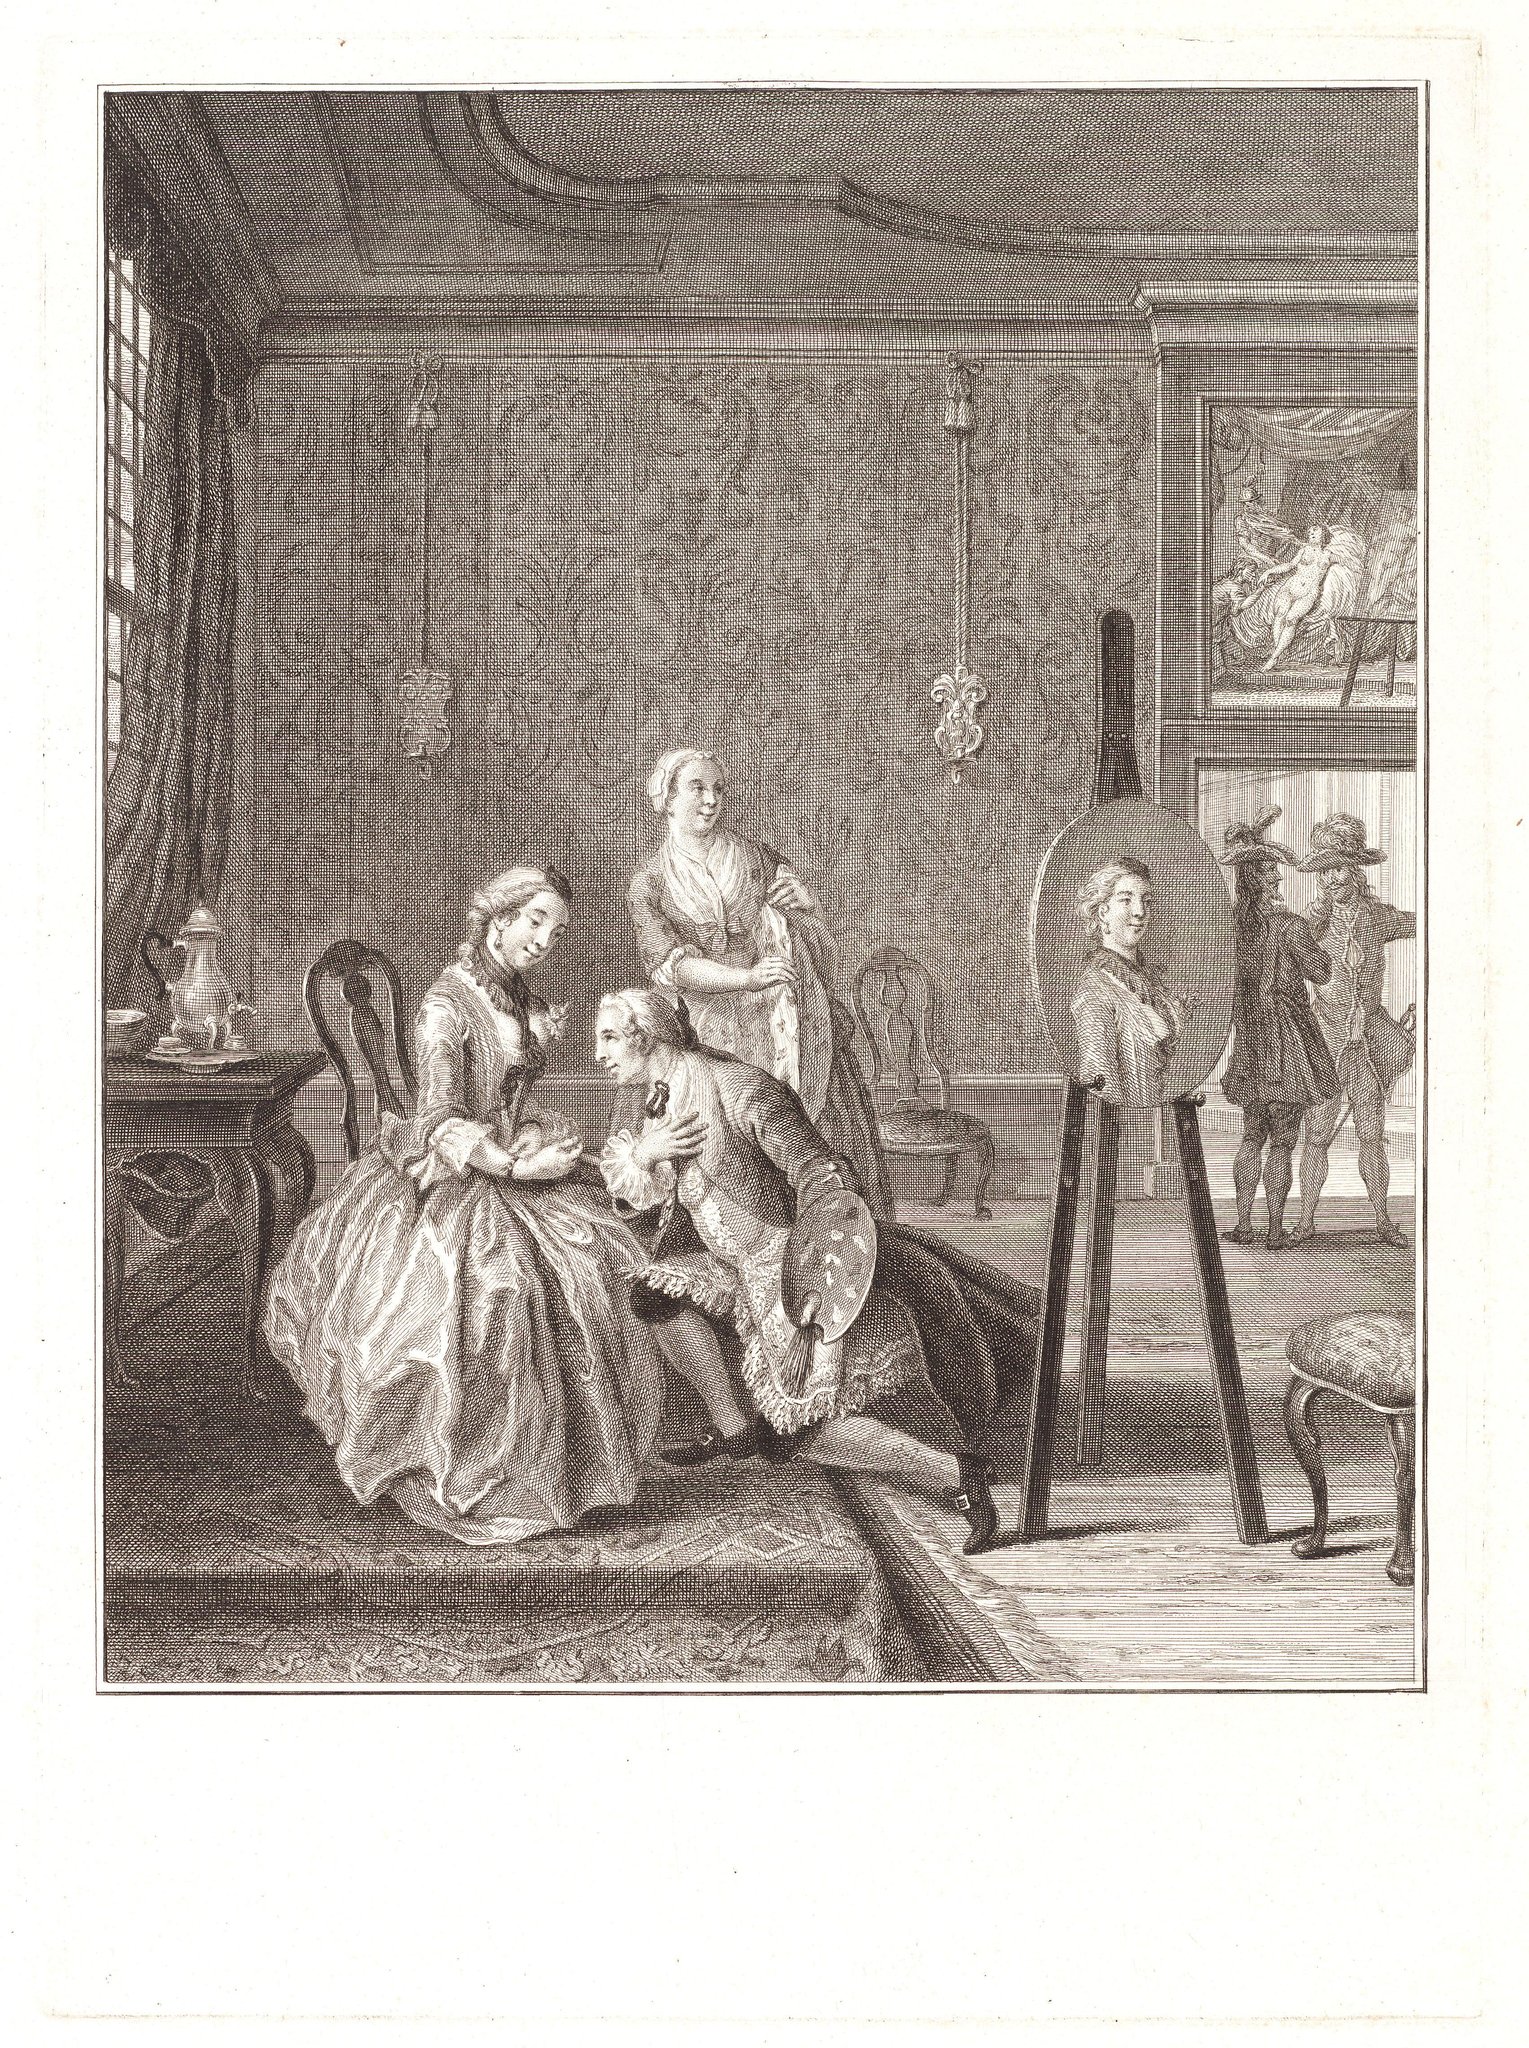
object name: print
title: De schilder door liefde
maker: pieter tanjé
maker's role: draughtsman, print maker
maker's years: 1706-1761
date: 1761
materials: paper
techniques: engraving, etching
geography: amsterdam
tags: kneeling figure, apelles paints campaspe and falls in love with her; alexander yields her to him, painter working from clothed model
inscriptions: collector's mark: Lugt 2488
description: De schilder Eduard verklaart Leonoor, wier portret hij vervaardigd heeft, zijn liefde. Bij de deur staat Leonoors jaloerse man Don Pedro, die door de schildersknecht bezig wordt gehouden. Boven de deur hangt een schilderij met een voorstelling van Alexander, die de schilder Apelles zijn minnares Campaspe ten geschenke geeft. Staat vóór alle tekst. Scène uit het tweede bedrijf van het toneelstuk De schilder door liefde, van Molière.